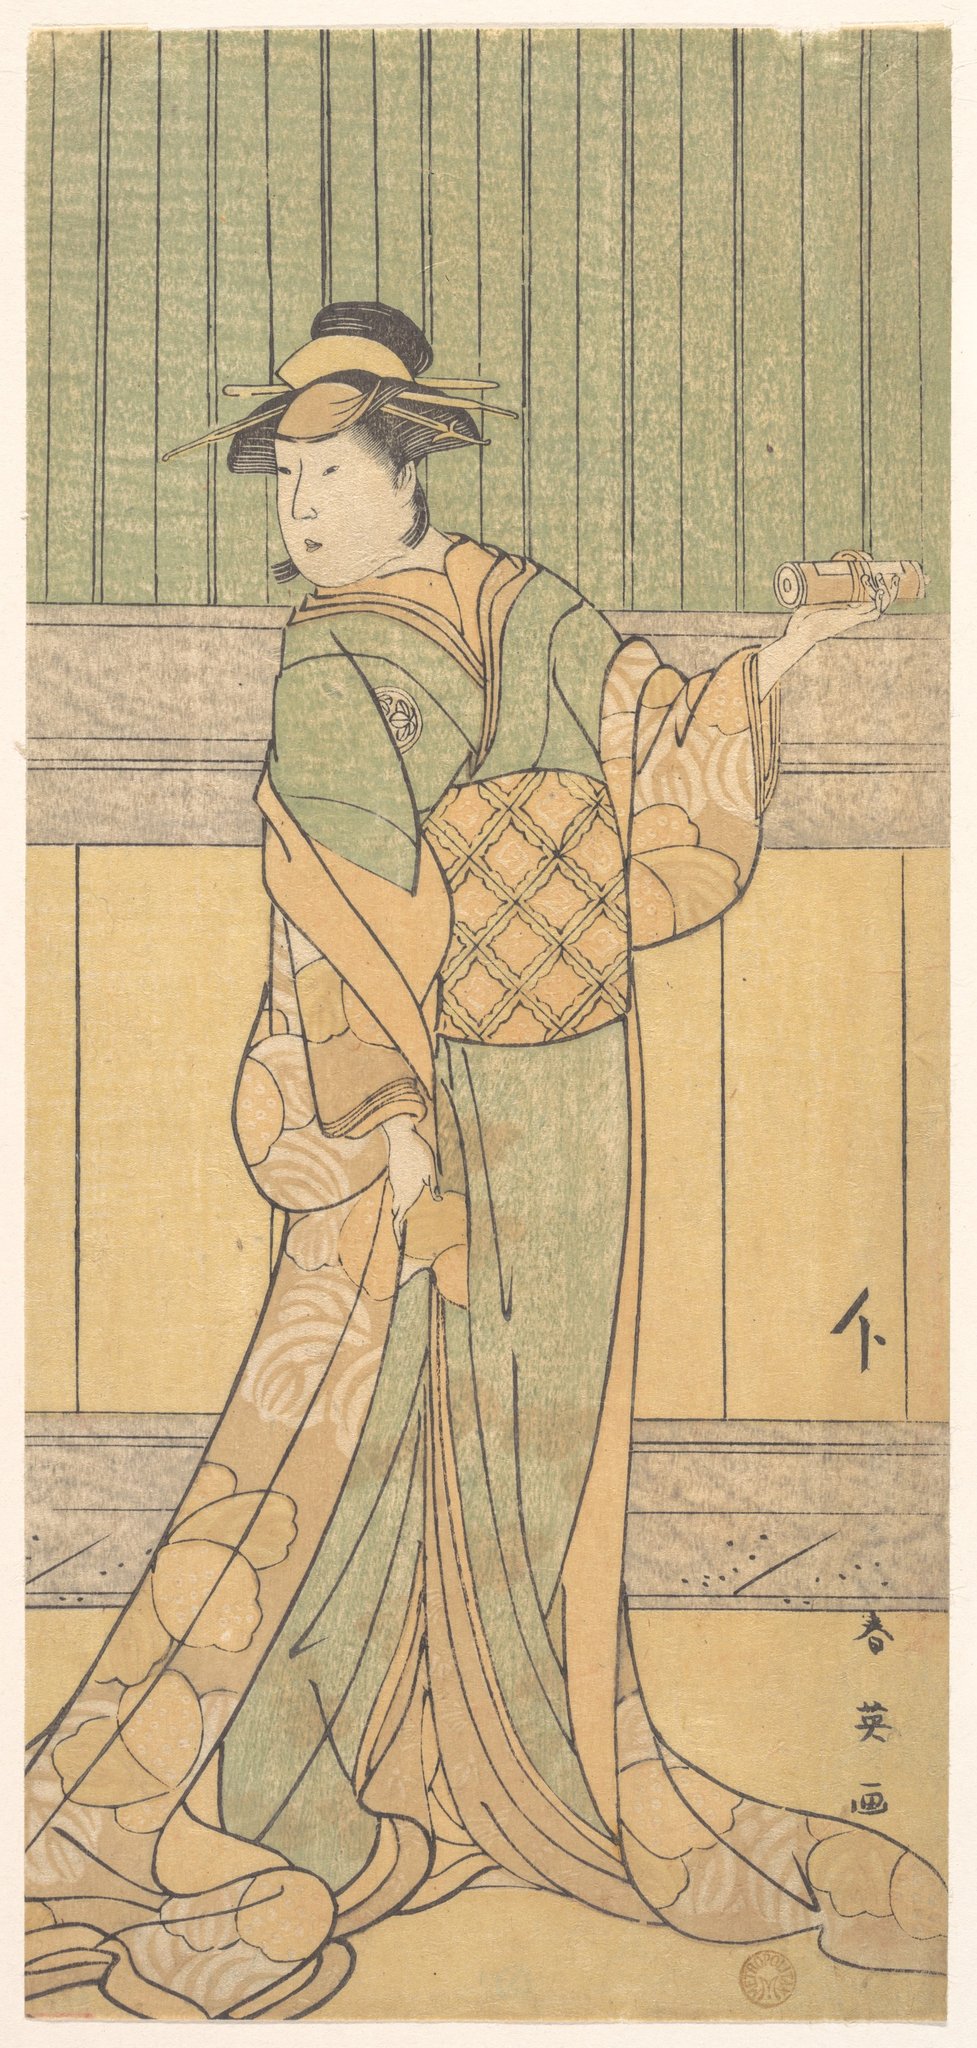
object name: print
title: Osagawa Tsuneyo as a Woman Standing in a Room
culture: japanese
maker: katsukawa shun'ei 勝川春英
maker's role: artist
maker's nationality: japanese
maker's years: 1762-1819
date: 1793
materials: ink, paper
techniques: woodblock print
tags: dresses,men,actors